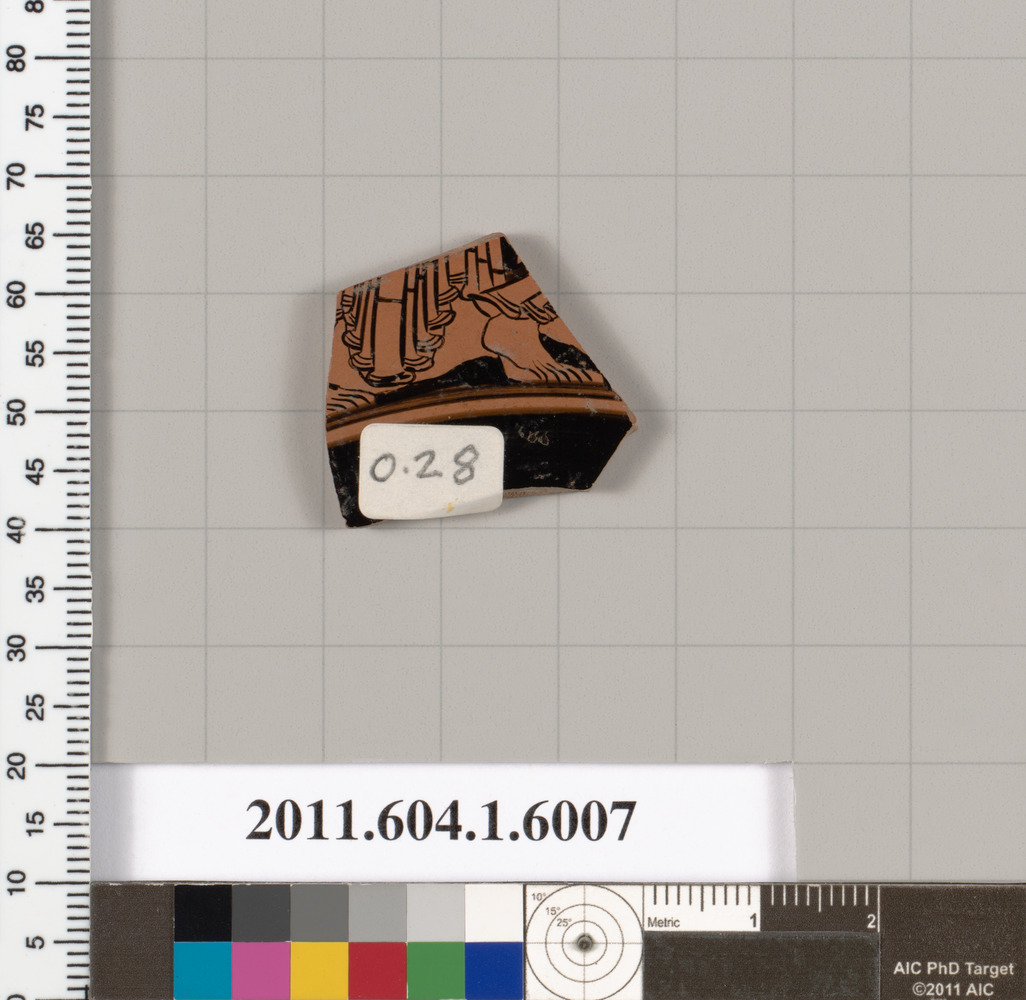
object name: kylix fragment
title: Terracotta fragment of a kylix (drinking cup)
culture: greek, attic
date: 510-500 BCE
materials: terracotta